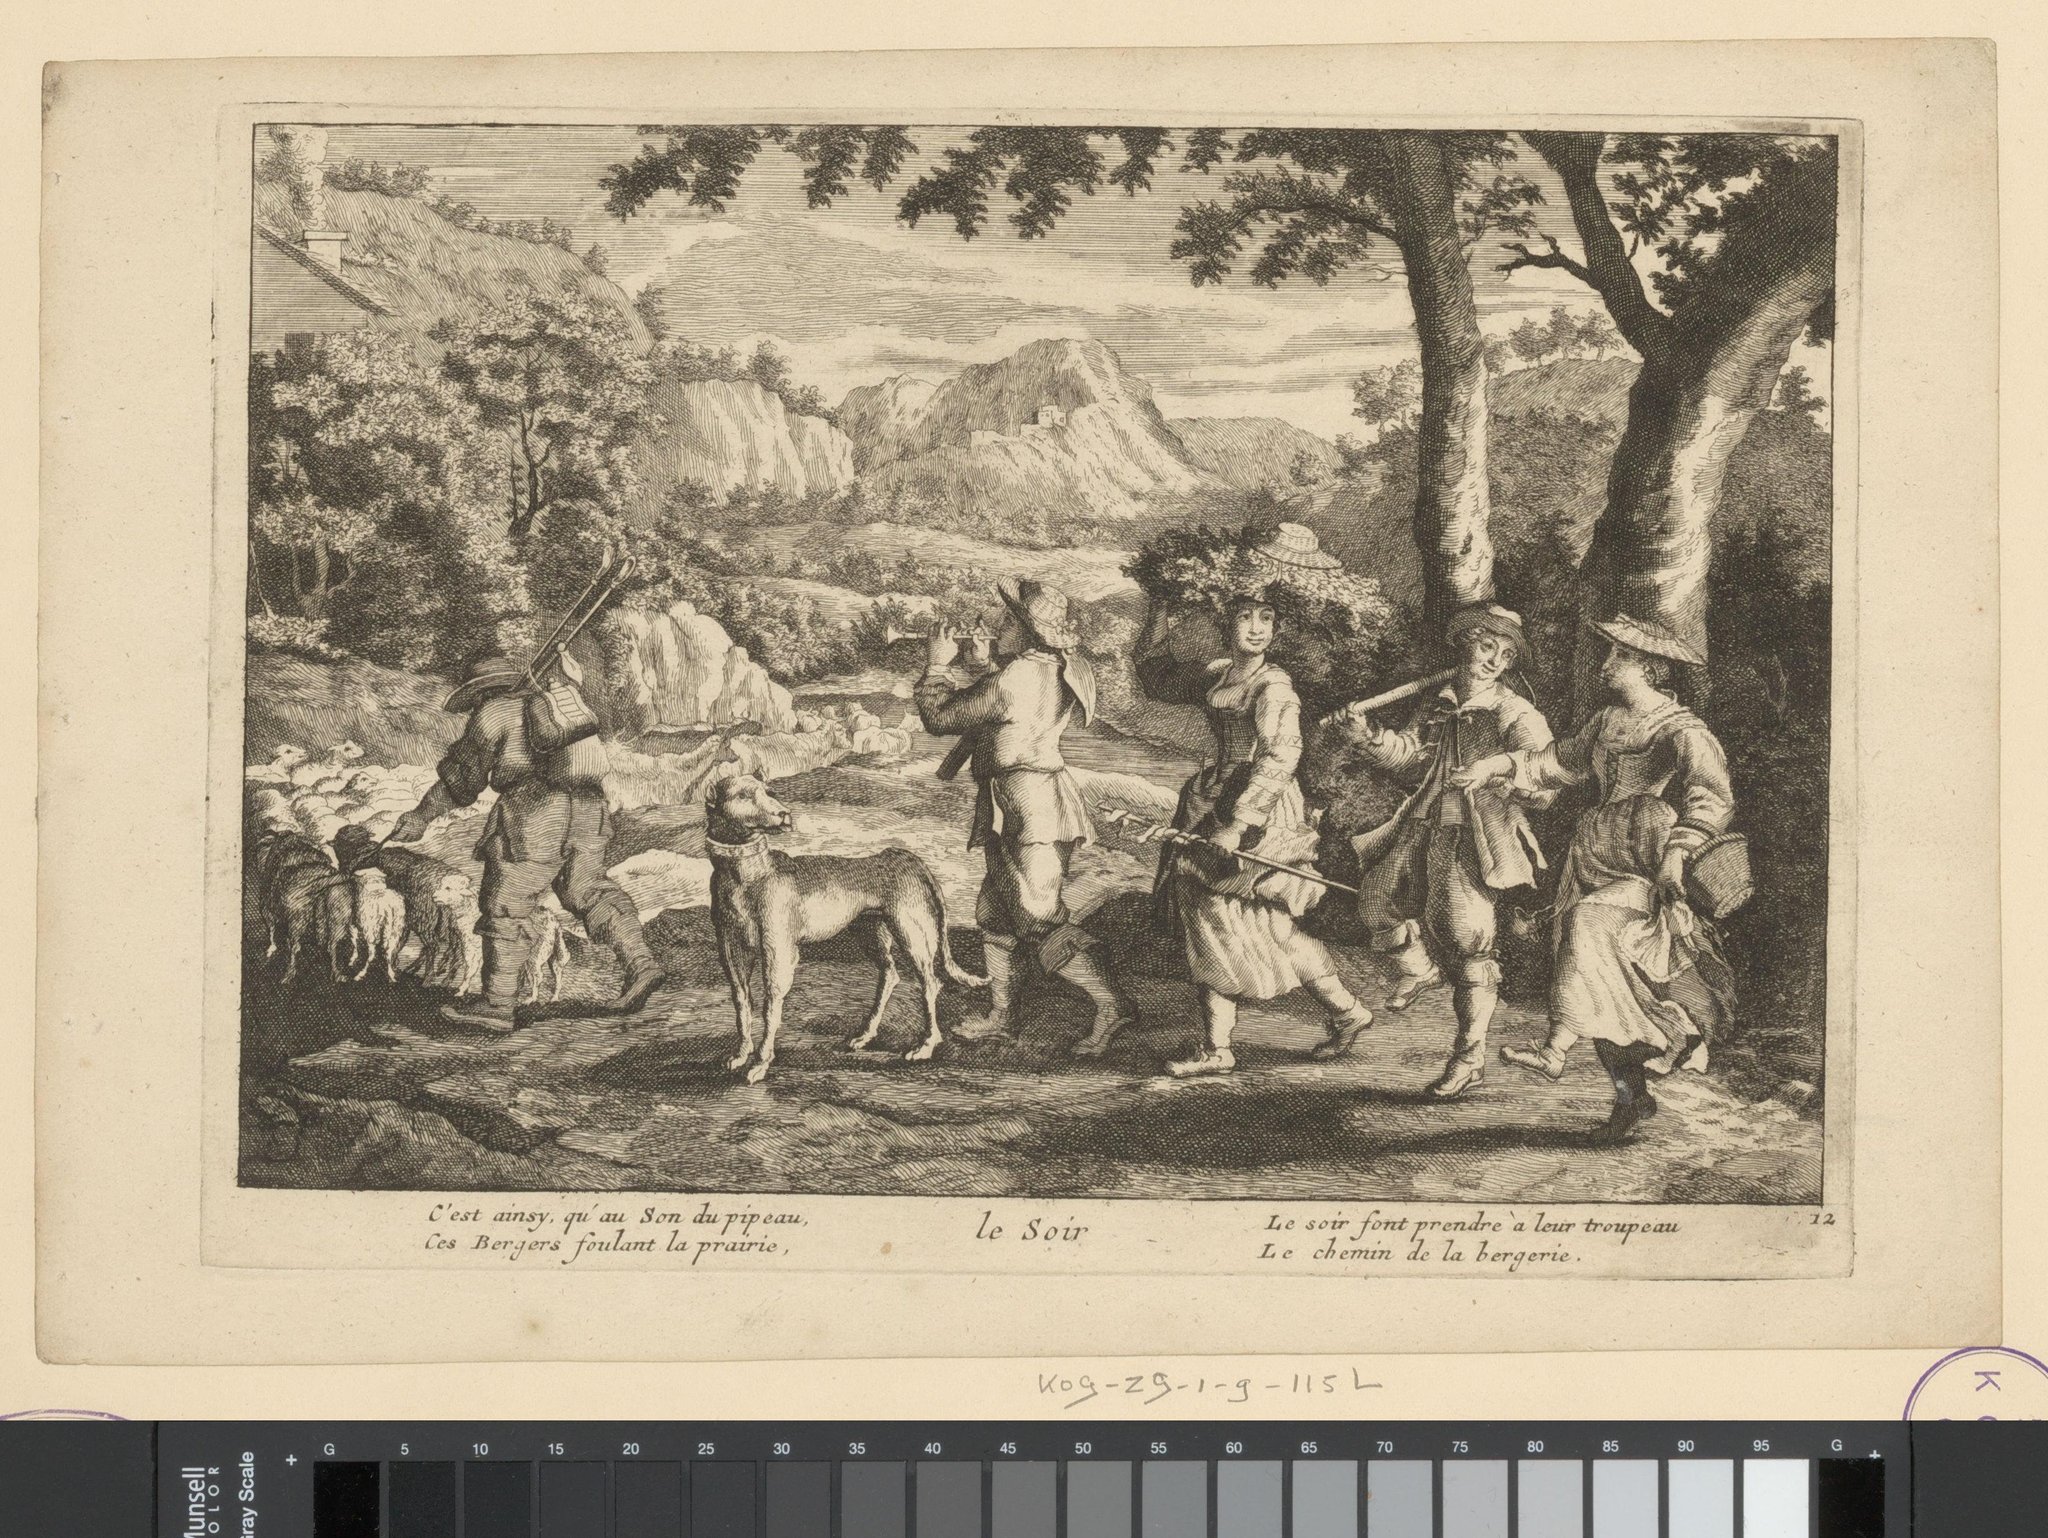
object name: print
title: Landelijke en pastorale scènes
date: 1670-1726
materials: paper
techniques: engraving, etching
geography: amsterdam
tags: herding, herdsman, herdswoman, shepherd, shepherdess, cowherd, etc., herd, flock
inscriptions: collector's mark: Lugt 1641, stamp:, stamp:, collector's mark: Lugt 1641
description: Genummerd rechtsonder: 12. Onderwerpsrubrieken binnen de Atlas Zeden en Gewoonten: Handel, nijverheid en verkeer, Boerenleven.